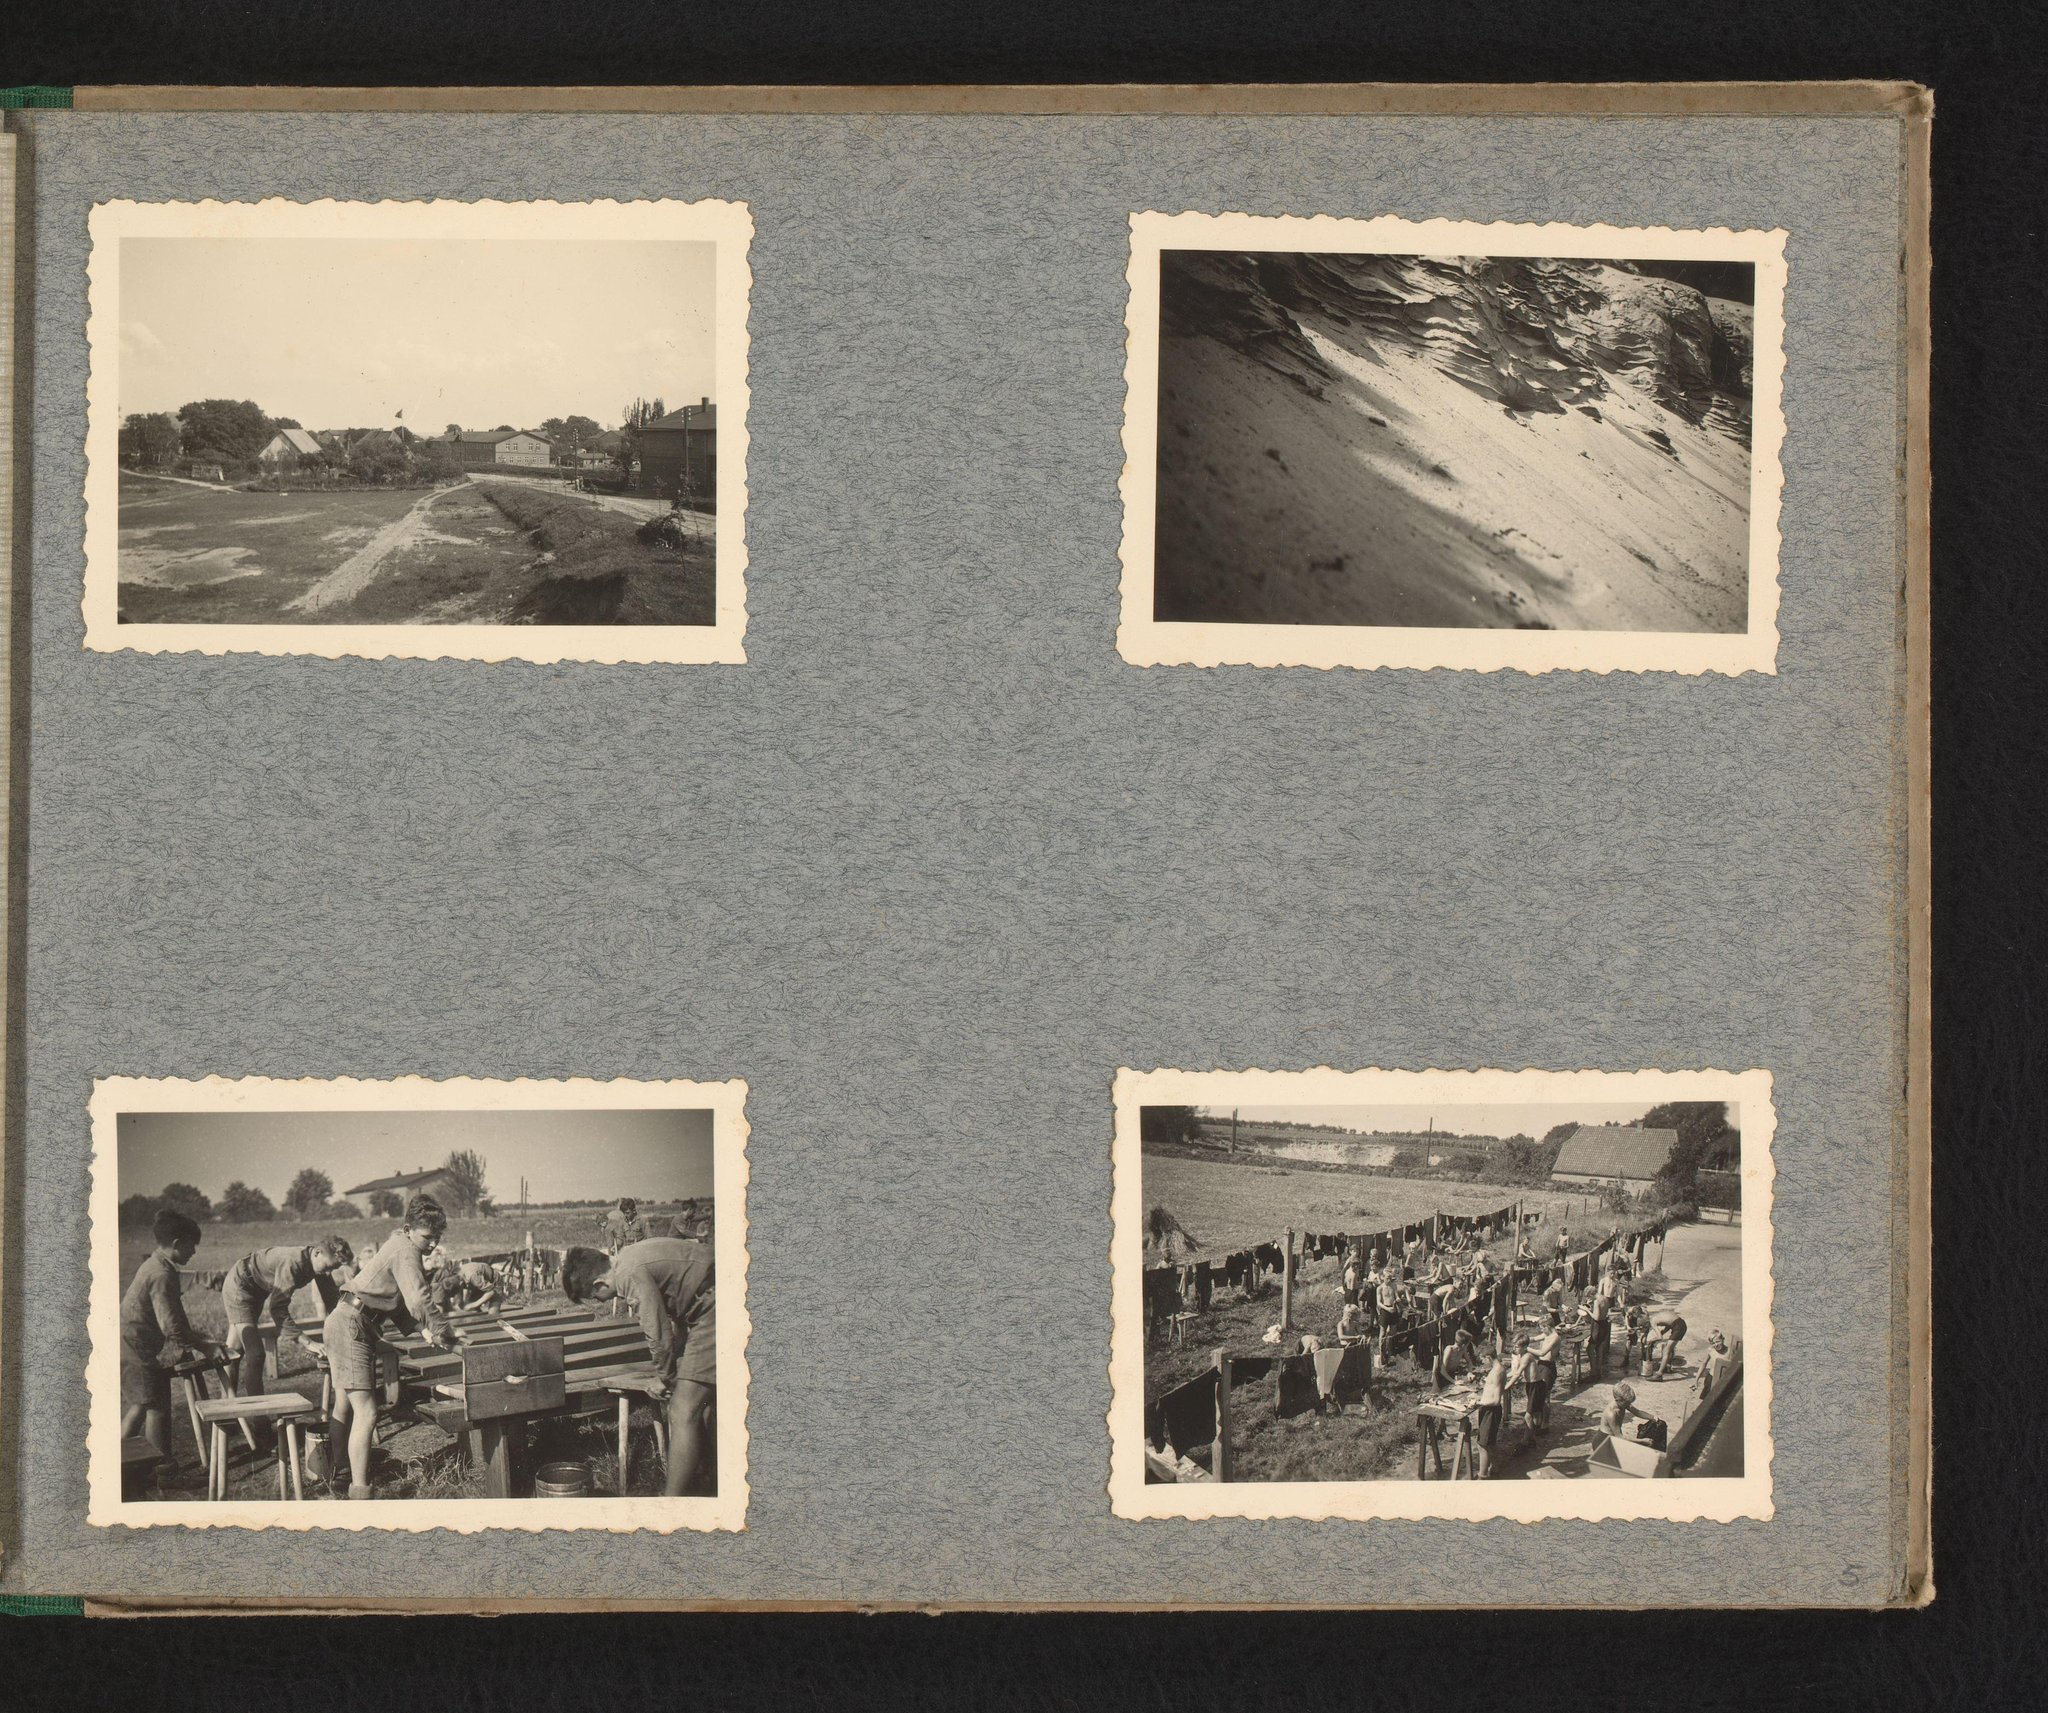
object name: photograph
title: Korvee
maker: Anonymous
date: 1935-1938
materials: cardboard, photographic support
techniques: gelatin silver print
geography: germany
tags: military training, assembling of military forces; mobilization, troop concentration, etc., germany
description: Albumblad met vier foto's van jongens van de Hitlerjugend op korvee bij de Landjahrlager 1935 in Wolmersdorf. Onderdeel van het Hitlerjugend fotoalbum.